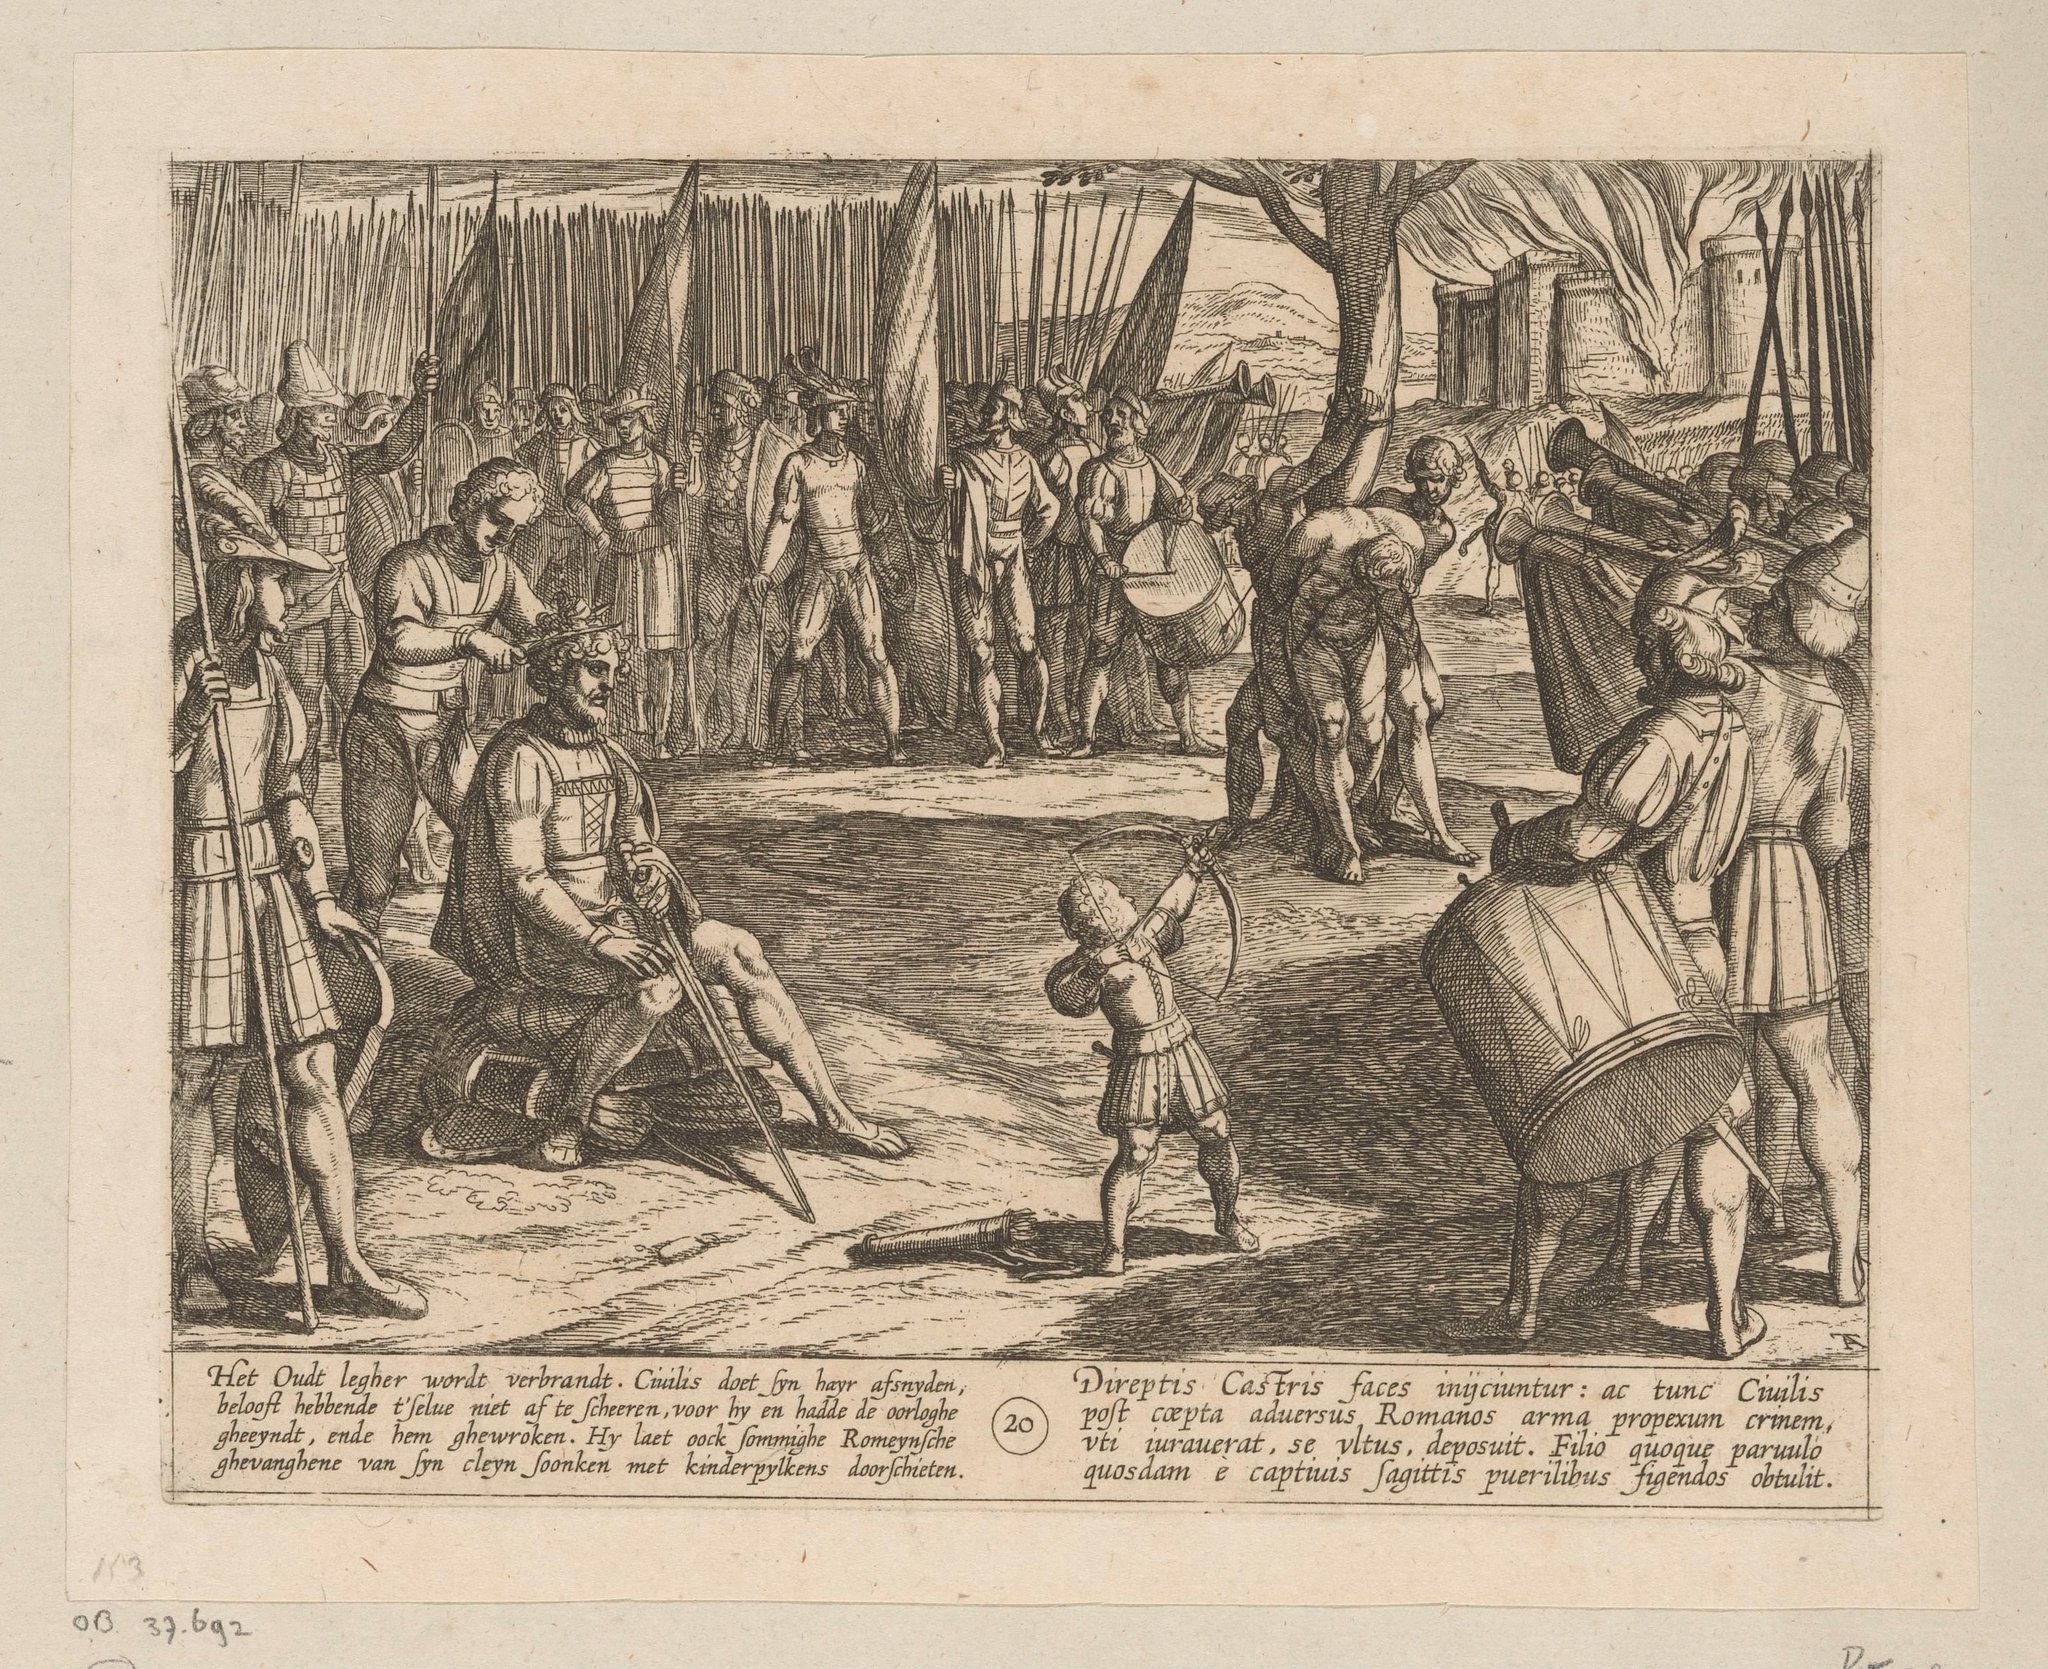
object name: history print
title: Civilis laat zijn haren knippen, 69-70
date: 1612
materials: paper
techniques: etching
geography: italy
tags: hair-cutting, extinct, 'historical' peoples (with name), netherlands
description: Civilis laat zijn haren knippen volgens zijn belofte om de Romeinen te verslaan. Tevens laat hij zijn kleinzoon pijlen schieten op Romeinse gevangenen. Prent nummer 20 in de serie prenten over de Bataafse Opstand: Batavorum cum Romanis bellum / à Corn. Tacito lib. IV & V. : Hist. olim descriptum, figuris nunc aeneis expressum, auctore Othone Vaenio Lugdunobatava = De Batavische oft oude Hollandtsche oorloghe teghen de Romeynen. Otto Vaenius, Antwerpen 1612. Onderaan twee verzen van vier regels in het Nederlands en in het Latijn. Zonder tekst op achterzijde.